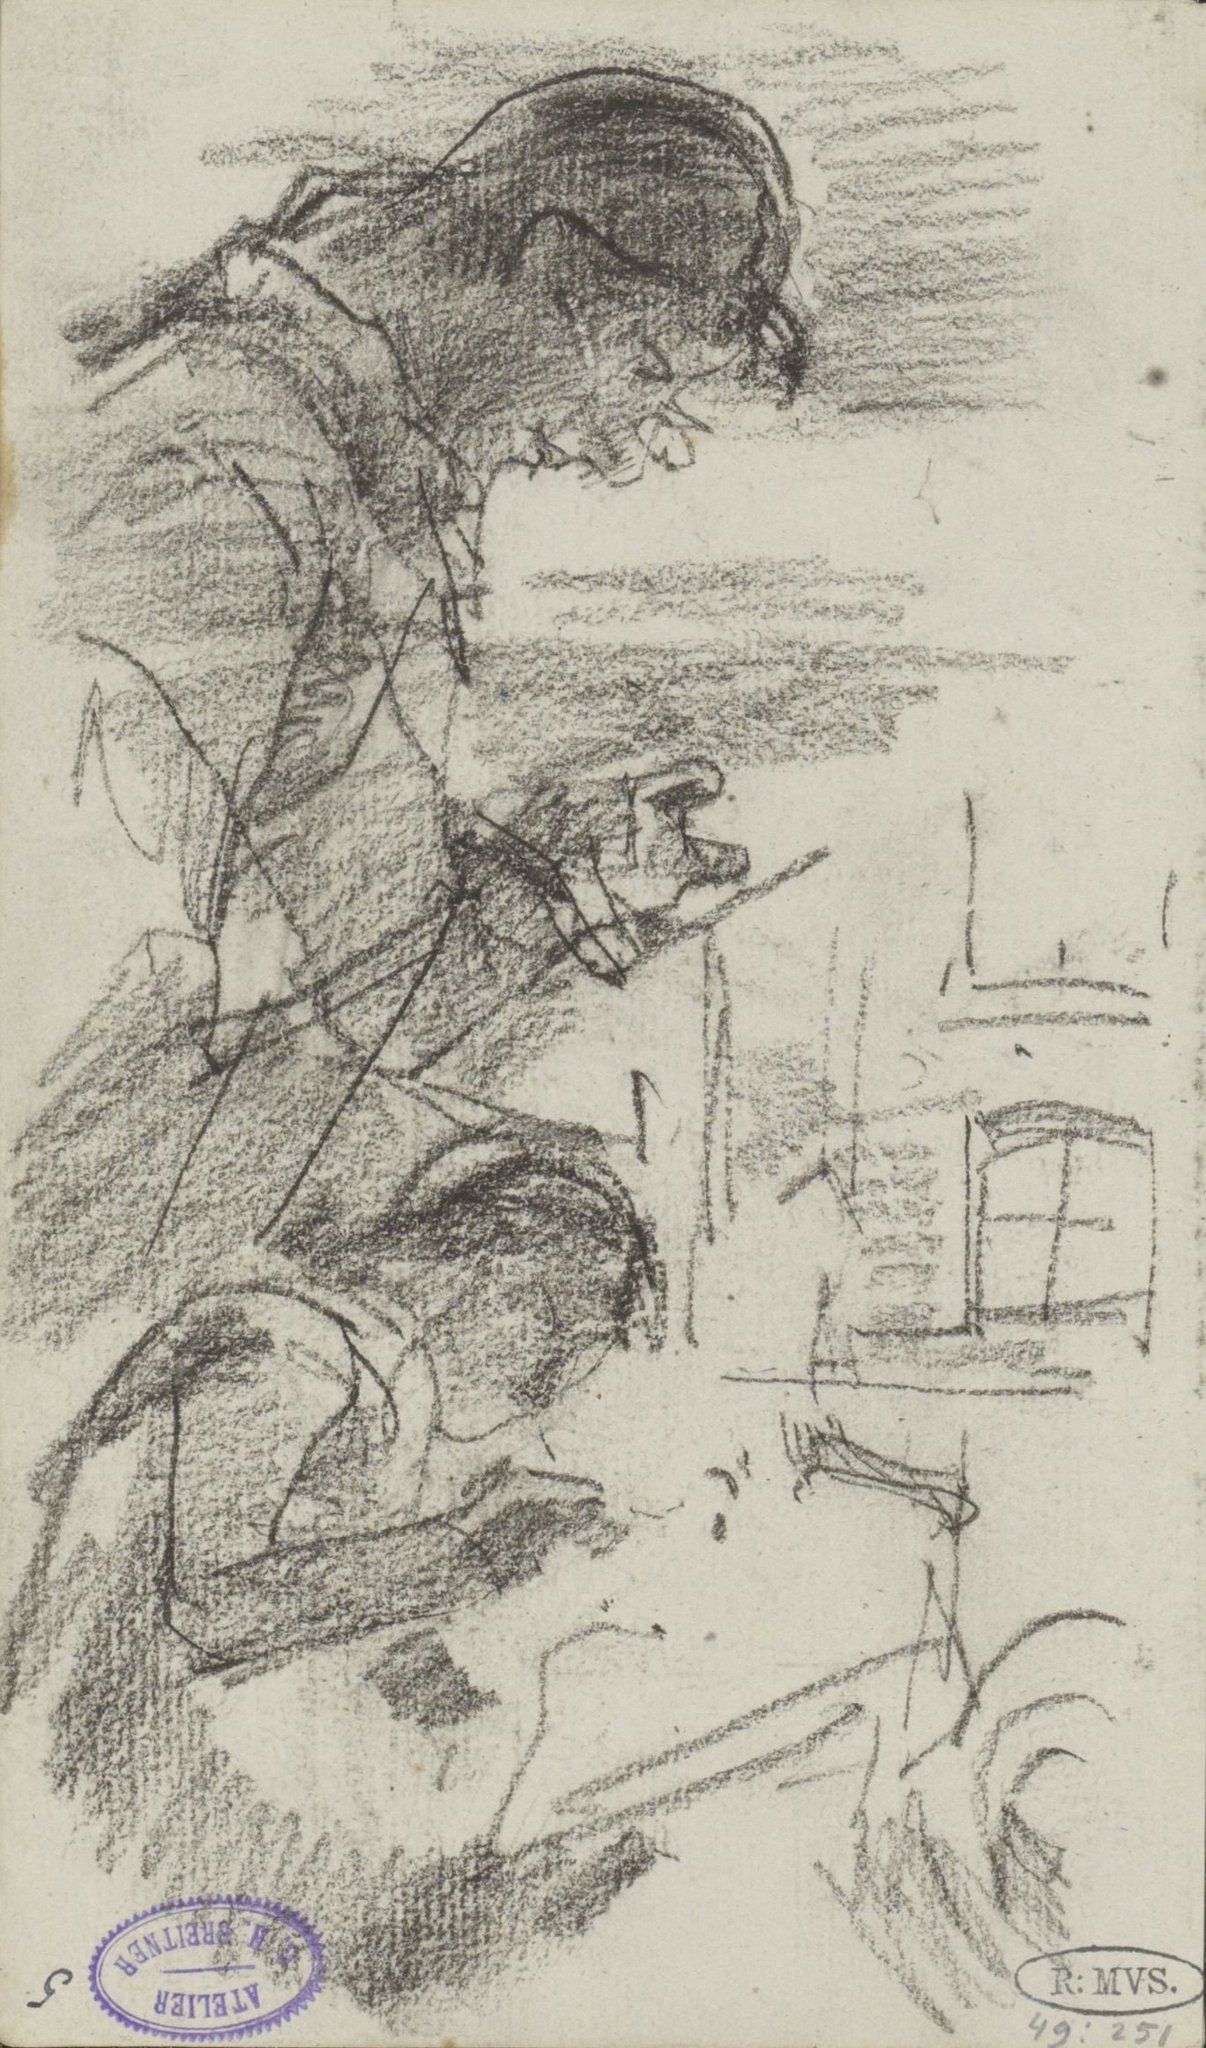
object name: drawing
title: Gevel en twee studies van een naaiende vrouw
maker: george hendrik breitner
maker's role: draughtsman, painter, print maker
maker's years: 1857-1923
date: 1882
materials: chalk, paper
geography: amsterdam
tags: façade (of house or building), sewing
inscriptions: workshop stamp: Lugt 291d, collector's mark: Lugt 2228